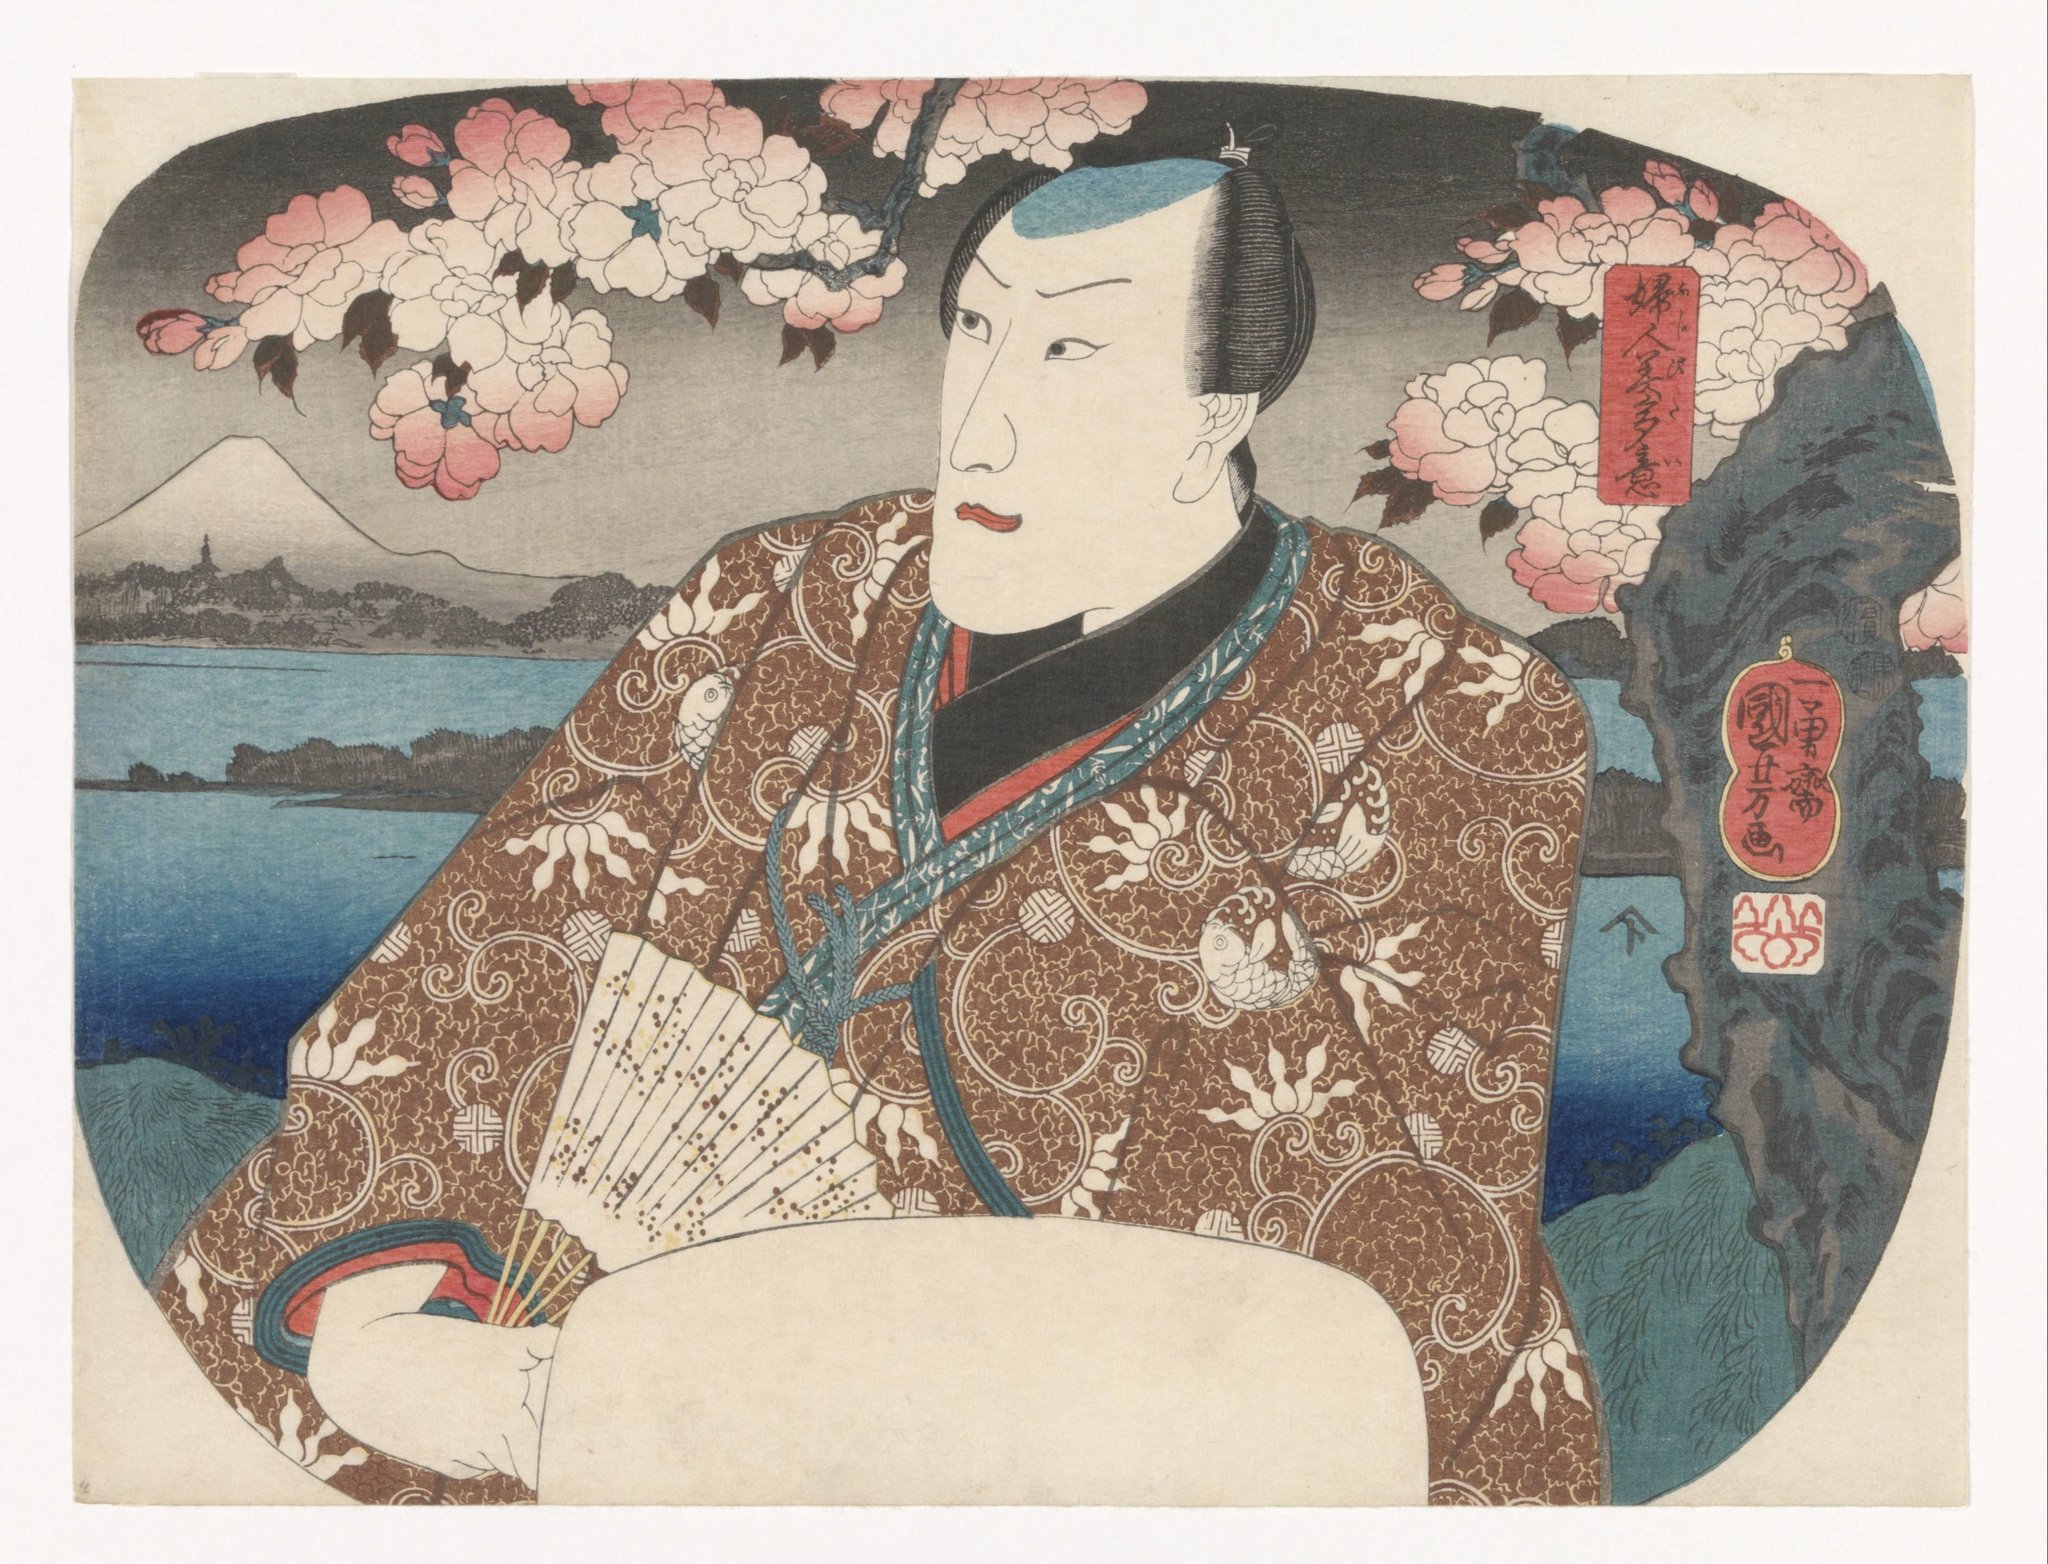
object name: print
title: Acteur met waaier onder kersenbloesem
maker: utagawa kuniyoshi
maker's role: draughtsman, print maker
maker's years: 1798-1861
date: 1849-1853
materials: paper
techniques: woodcut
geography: japan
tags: portrait of actor, actress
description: Acteur (waarschijnlijk Iwai Kumesaburô III ) met waaier in zijn hand staat onder een bloeiende kersenboom en kijkt uit over een meer met de berg Fuji op de achtergrond. Waaierprent.